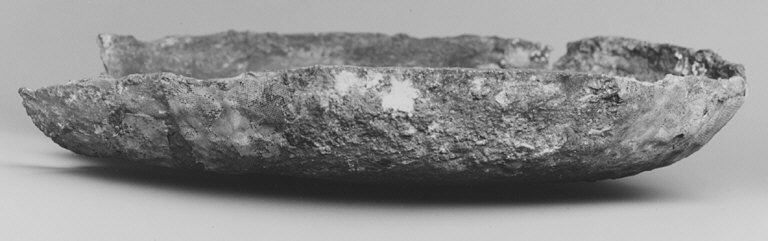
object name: bowl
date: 7000 BCE-330 CE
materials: silver